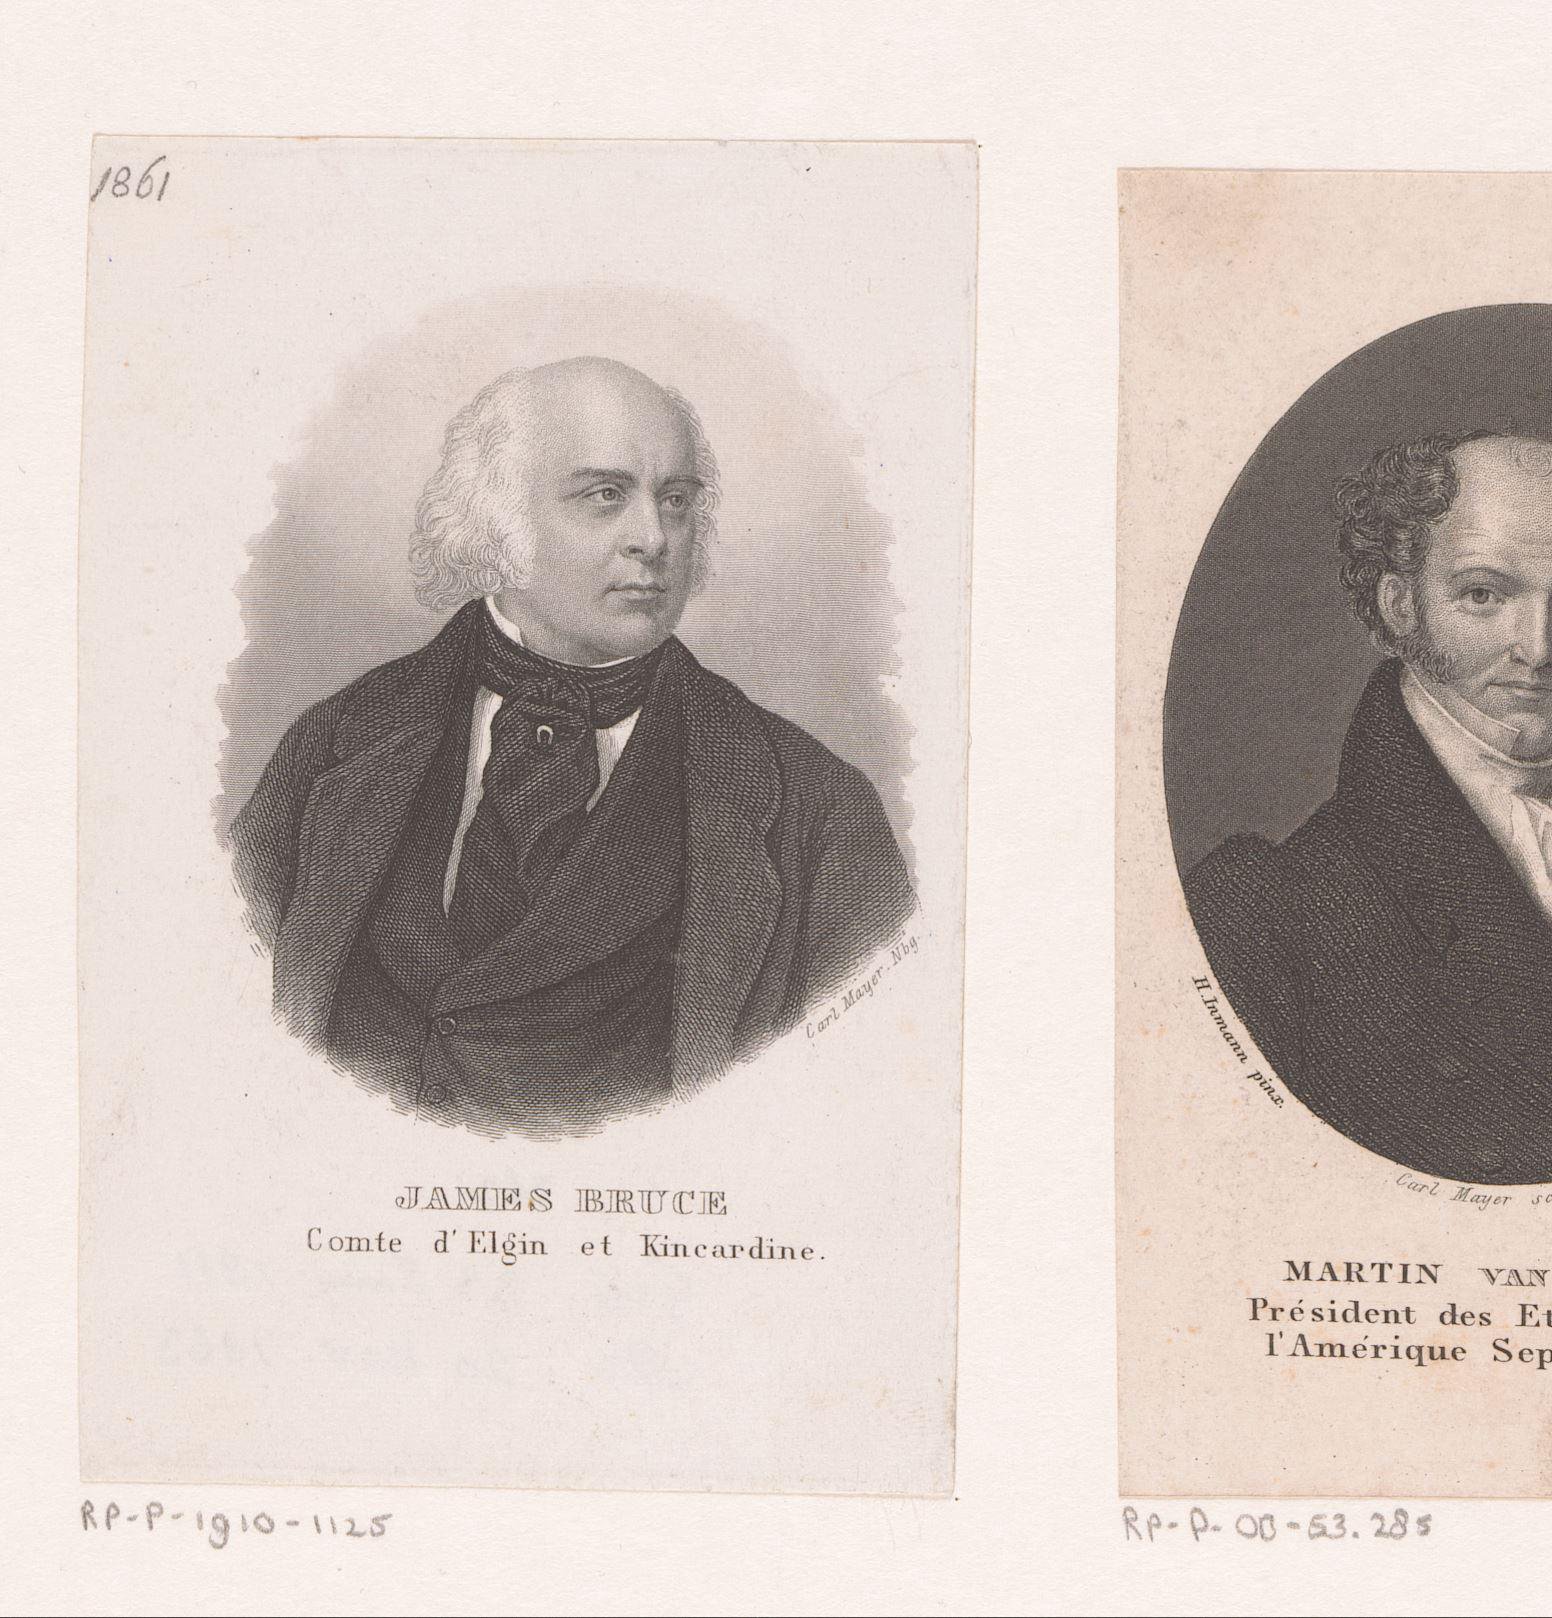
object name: book illustration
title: Portret van James Bruce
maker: carl mayer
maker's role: print maker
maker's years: 1798-1868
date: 1811-1868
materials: paper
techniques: engraving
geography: nuremberg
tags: historical persons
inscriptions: collector's mark: Lugt 2228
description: Vermoedelijk afkomstig uit: Almanach de Gotha, 1861